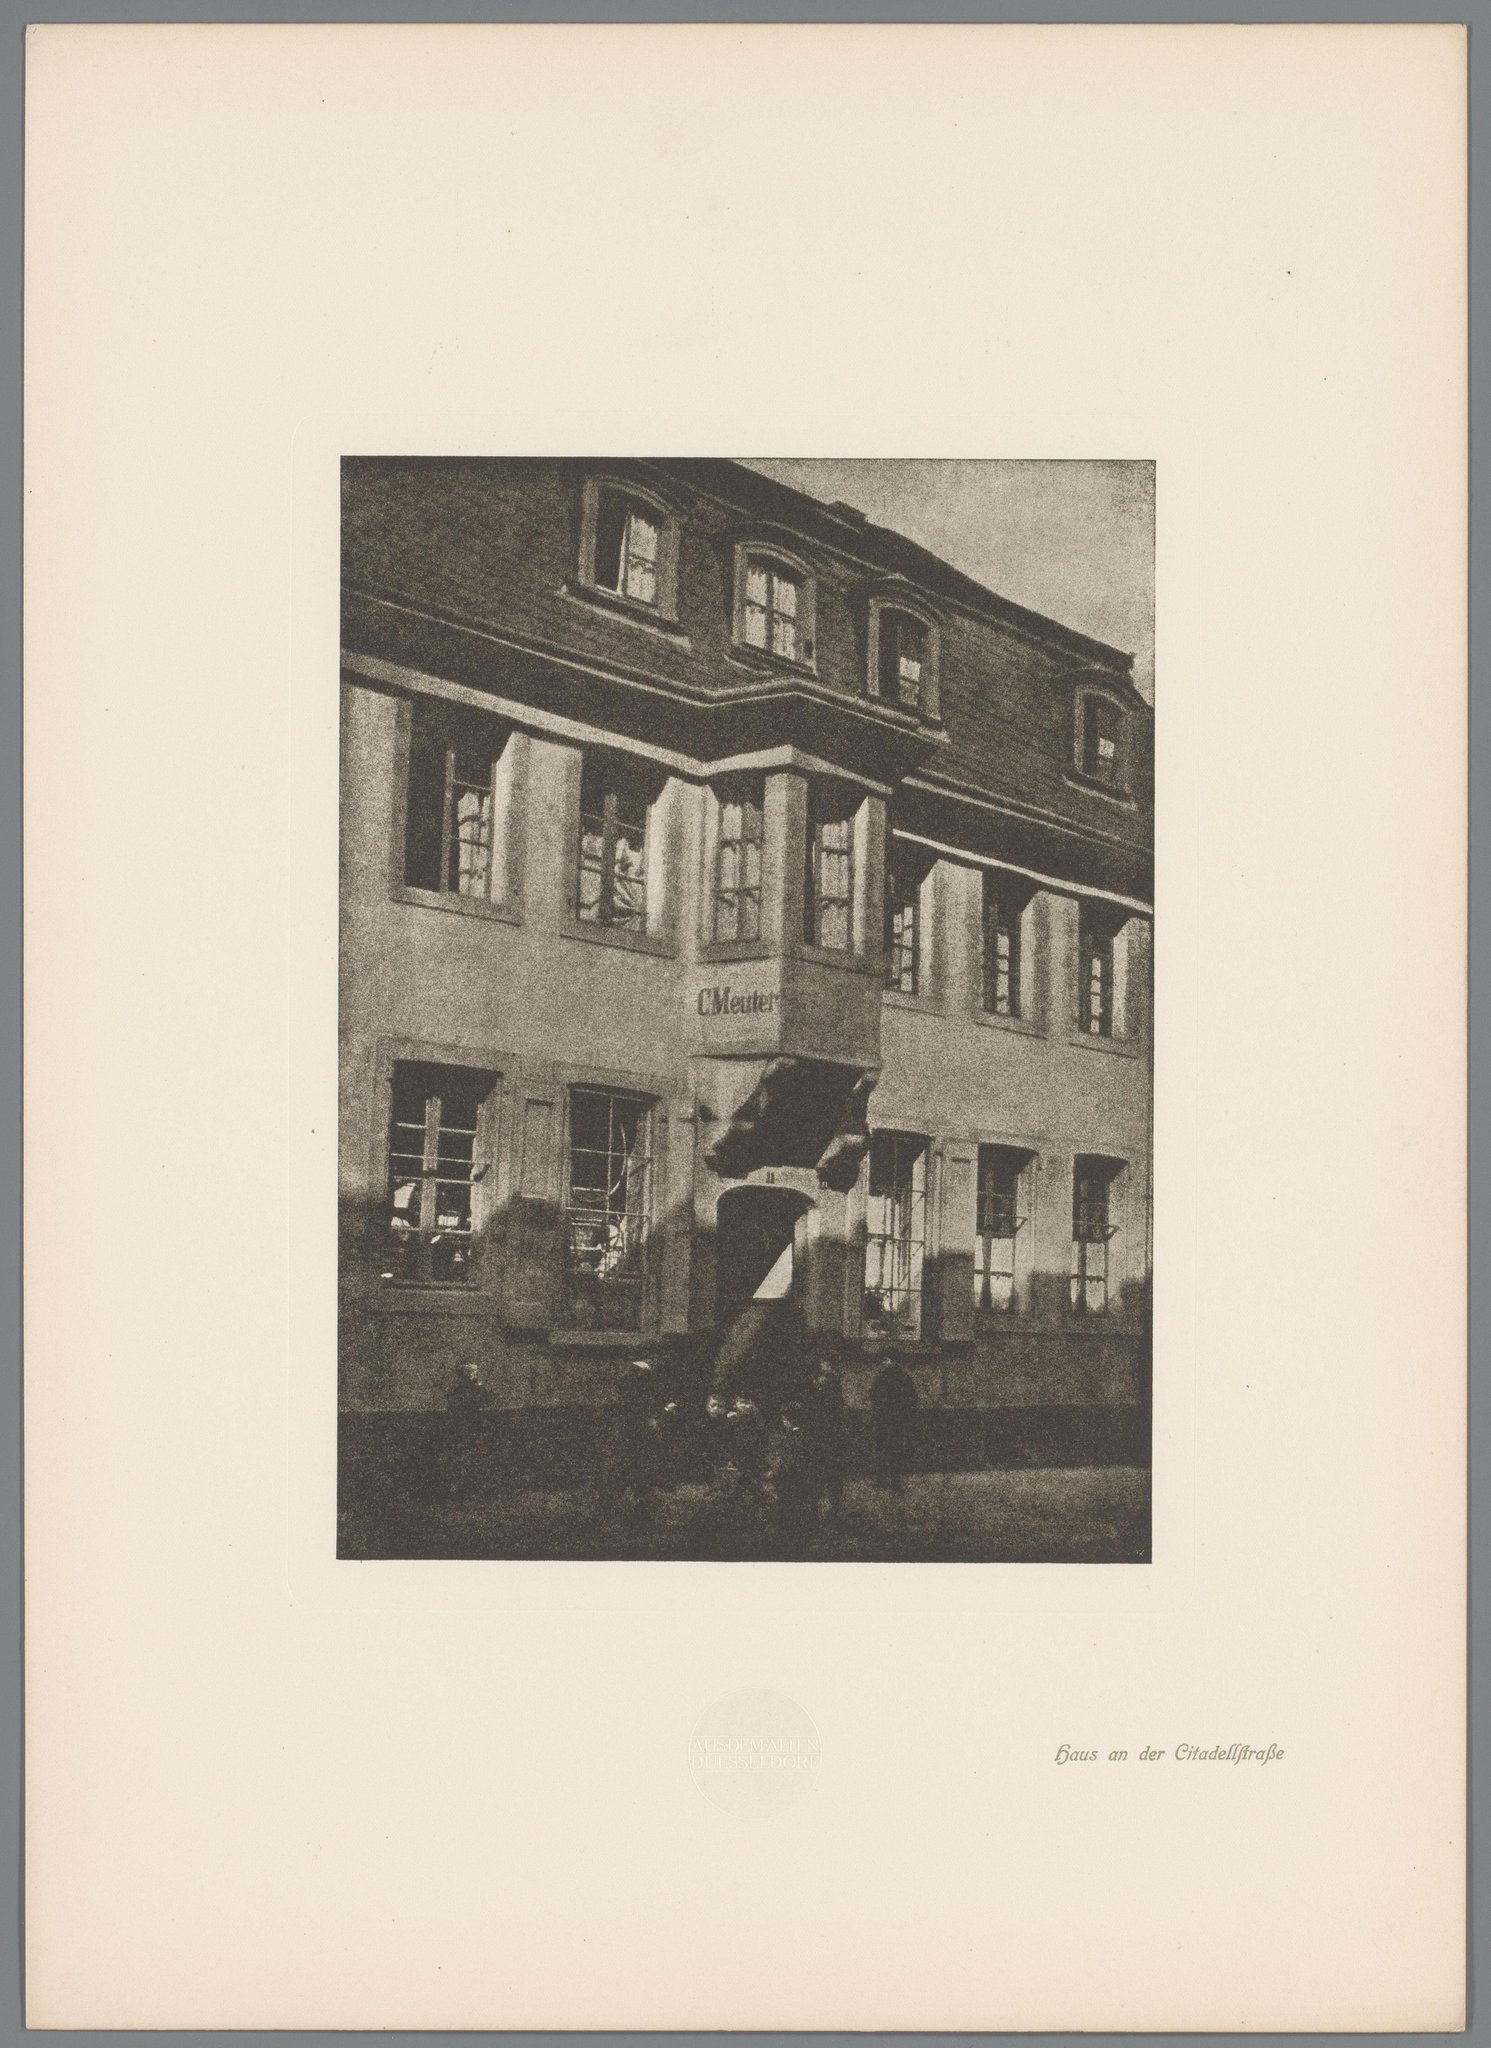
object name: reproduction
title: Reproductie van een gomdruk van een huis in de Citadellstraße in Düsseldorf door Erwin Quedenfeldt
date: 1902-1907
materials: paper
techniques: autotype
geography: offenbach am main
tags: urban housing